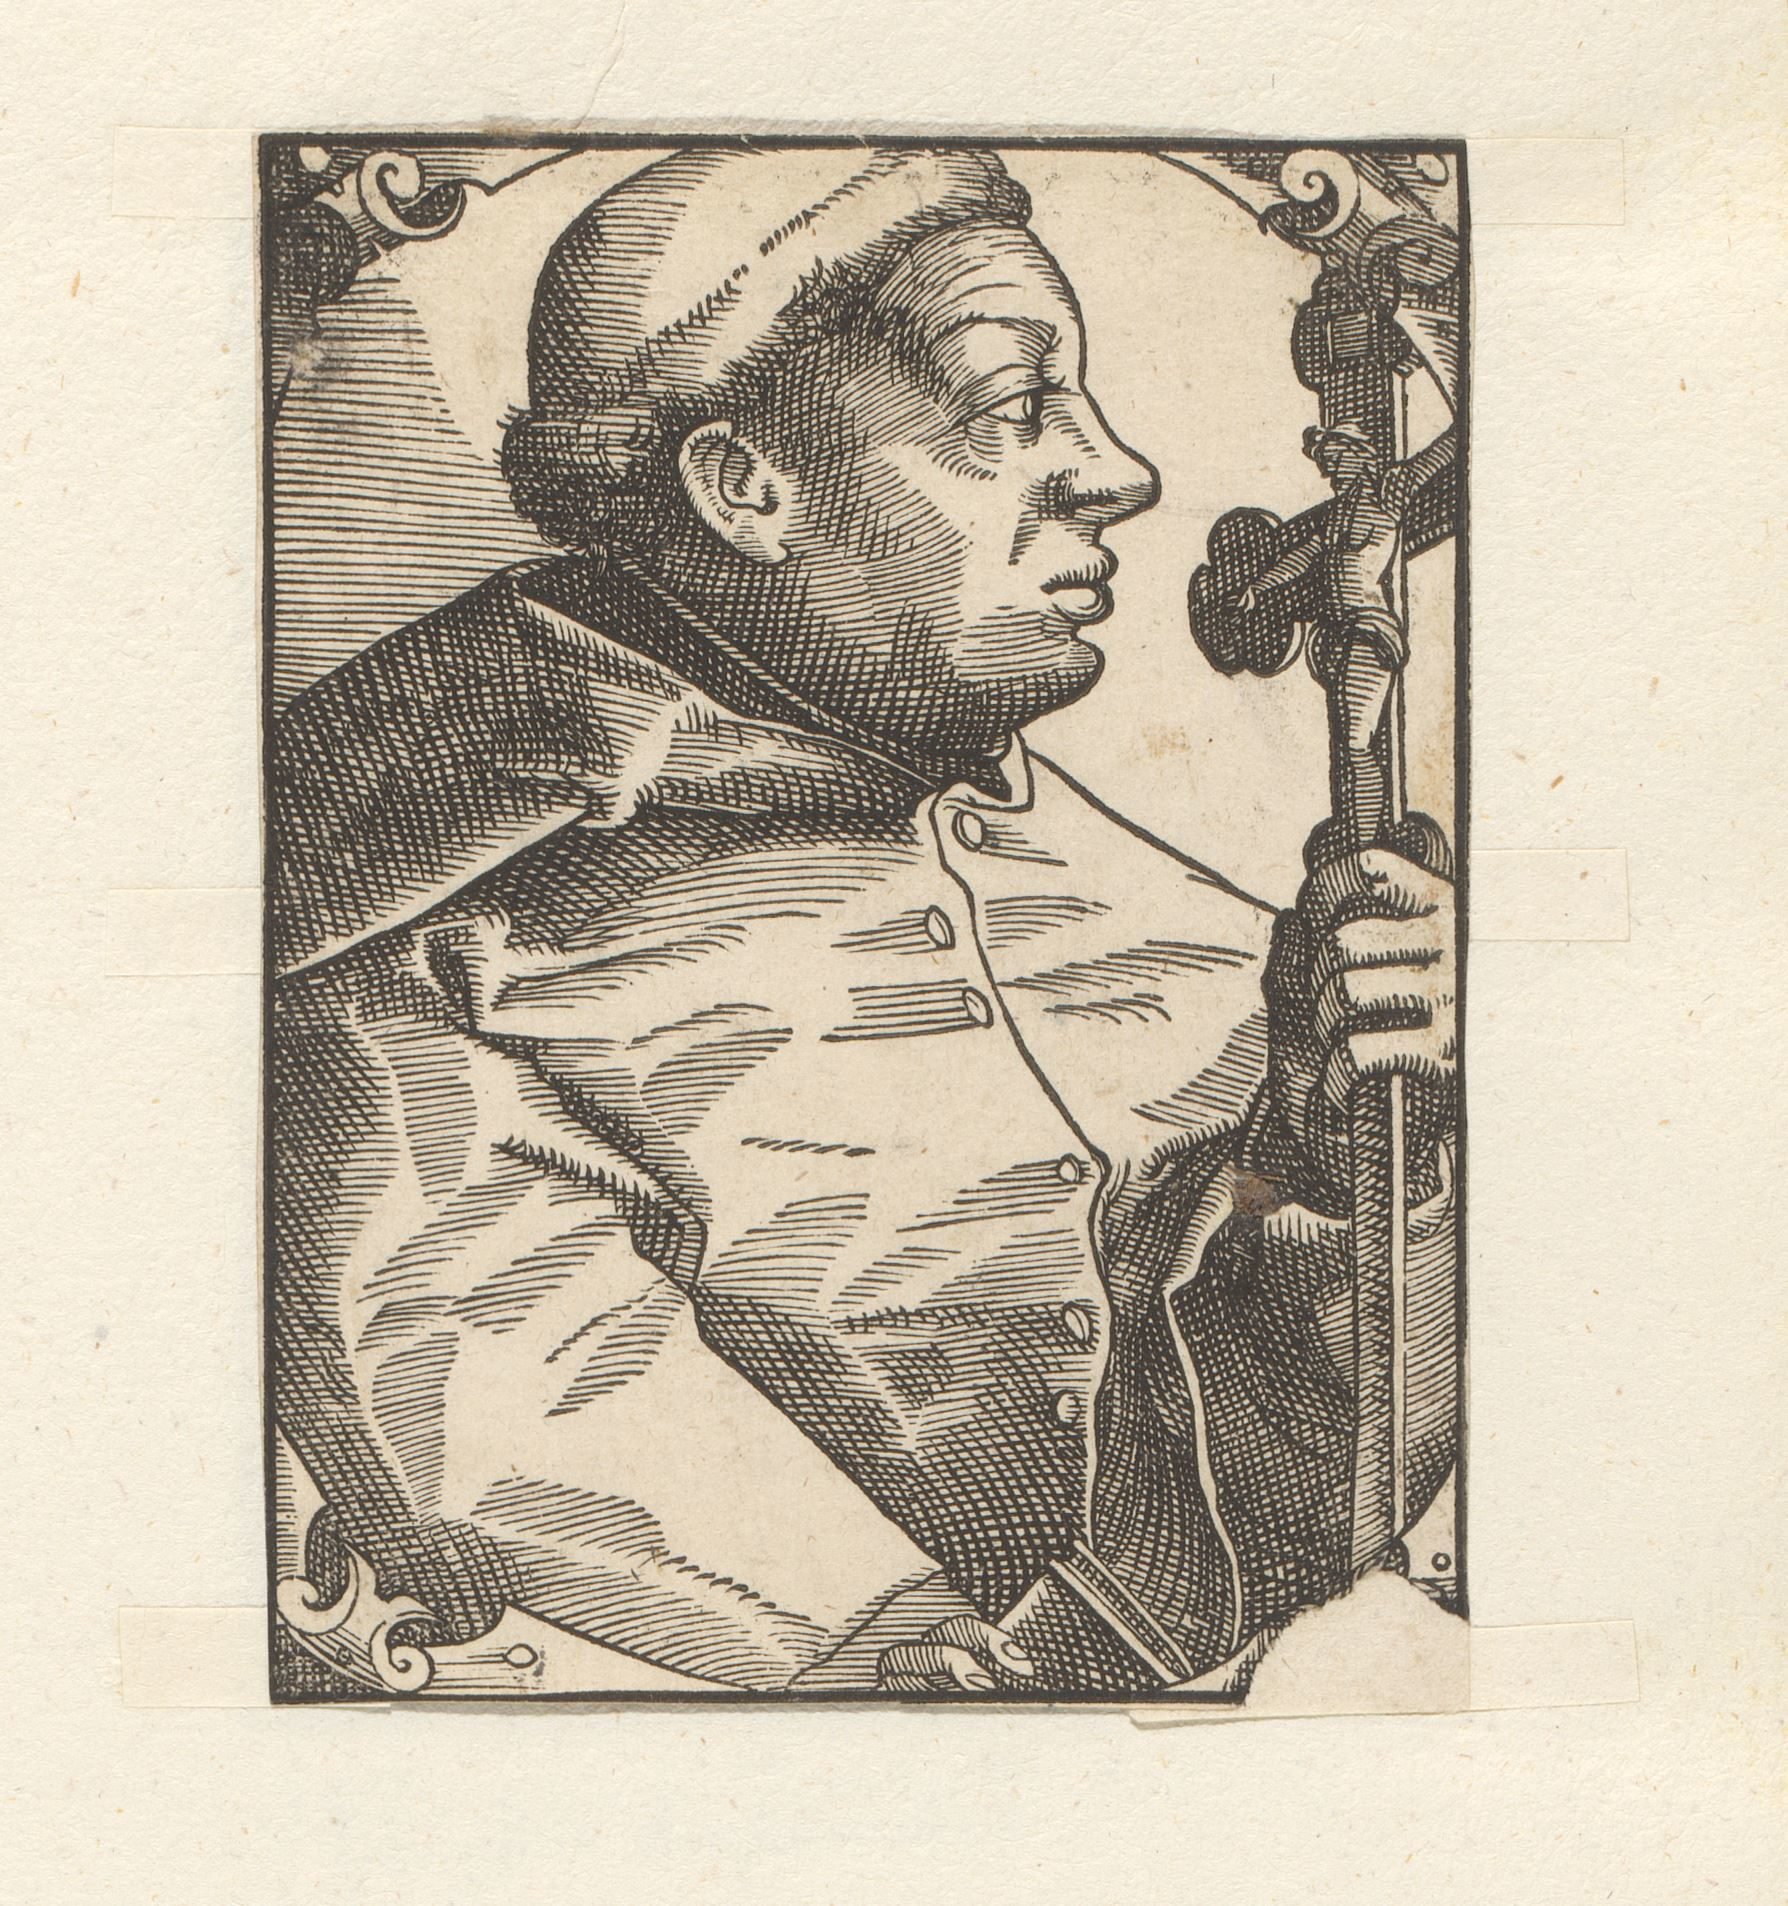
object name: book illustration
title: Portret van Julius Caesar Scaliger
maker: Anonymous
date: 1549-1584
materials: paper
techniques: woodcut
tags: julius caesar scaliger, cardinal, historical persons, portrait of a writer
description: Prent gebruikt in: Reusner, Nikolaus. Icones Sive Imagines Vivae. Bazel: Conrad Waldkirch, 1589.